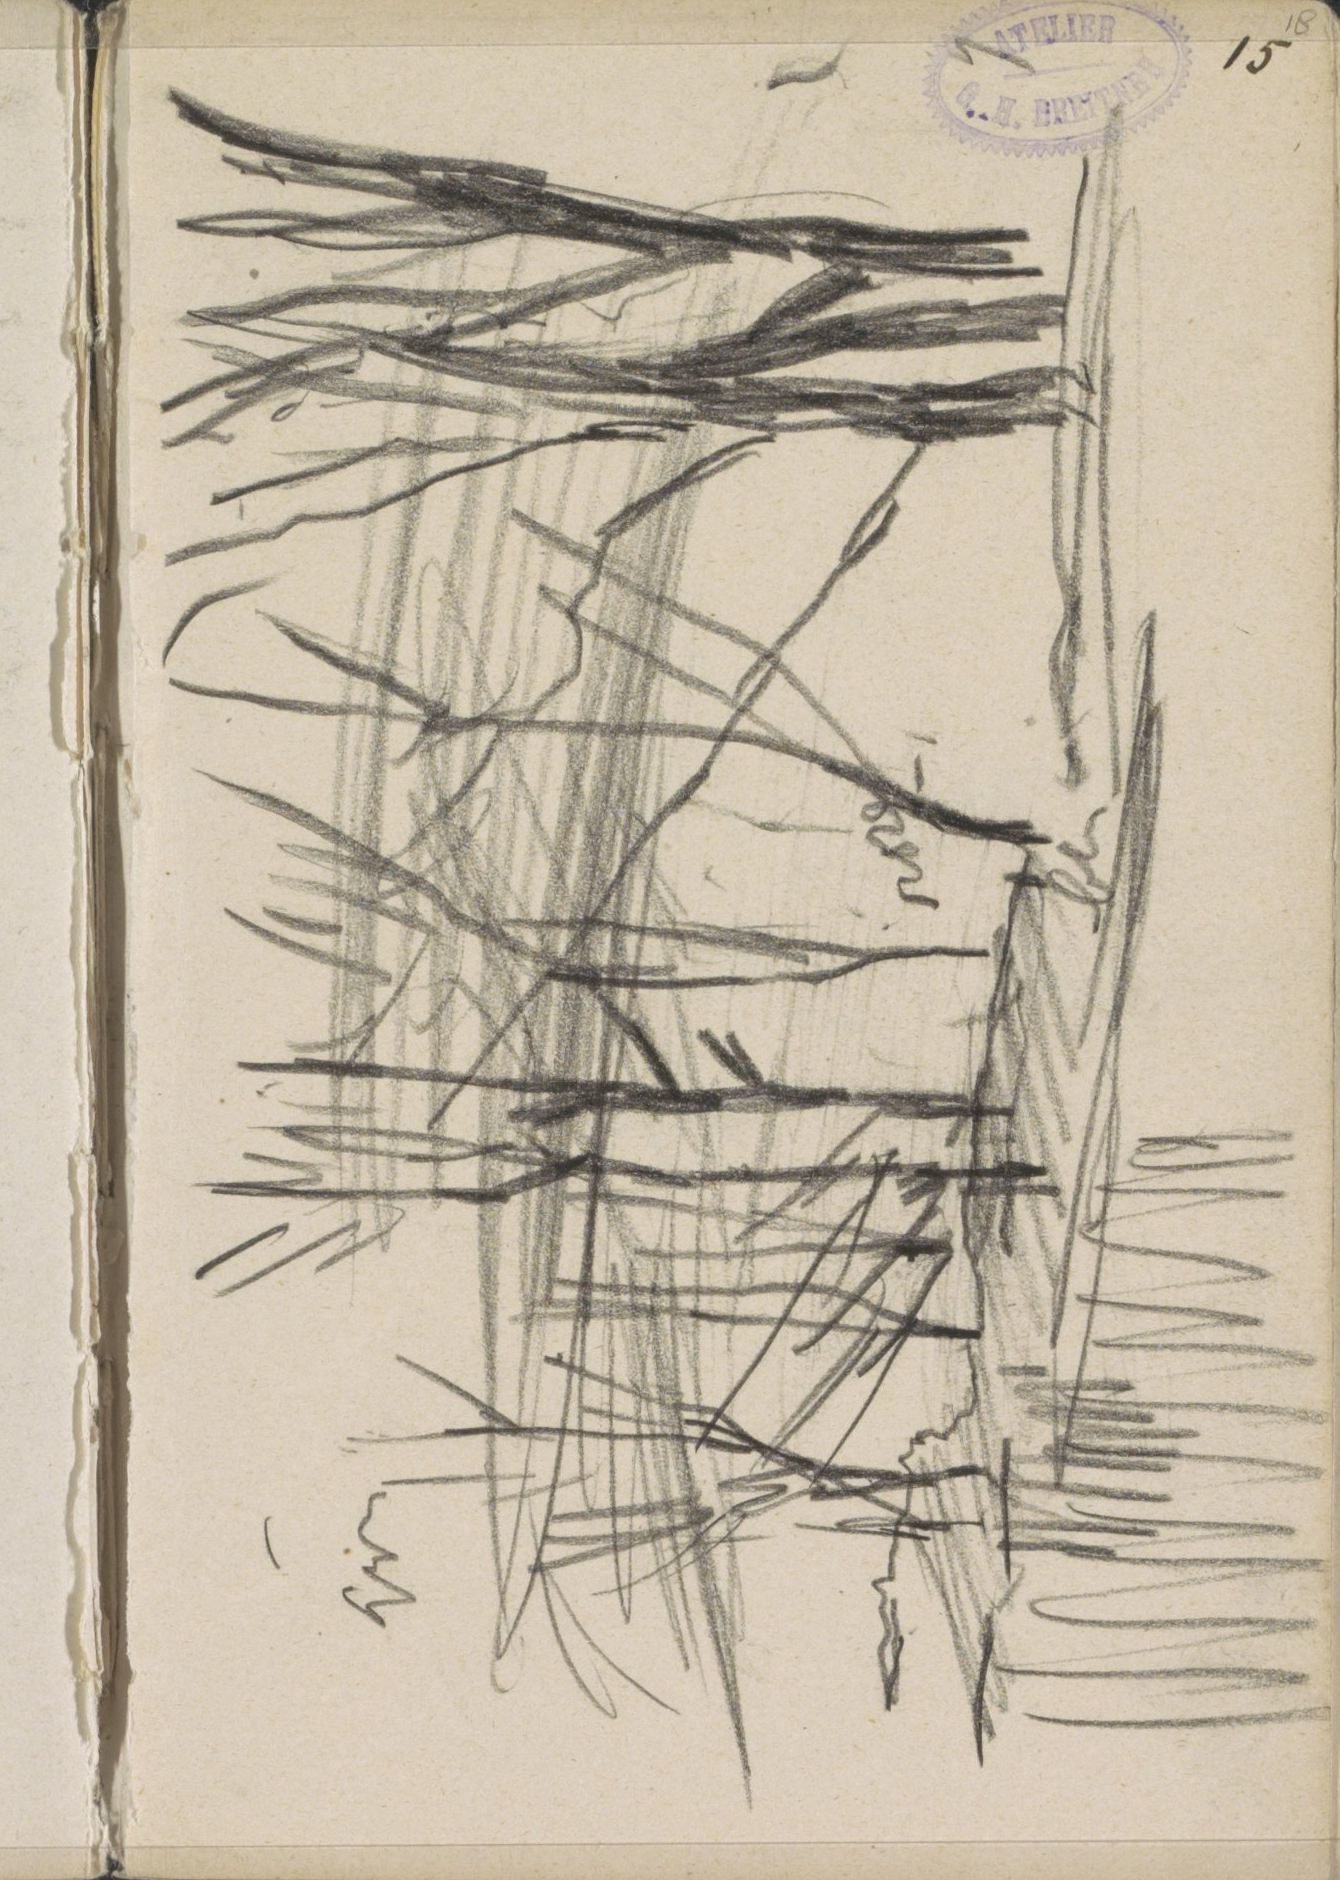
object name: sketchbook leaf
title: Bomen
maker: george hendrik breitner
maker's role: draughtsman, painter, print maker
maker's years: 1857-1923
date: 1912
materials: chalk, paper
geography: amsterdam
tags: trees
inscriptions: workshop stamp: Lugt 291d, :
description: Pagina 18 uit een schetsboek met 16 bladen.